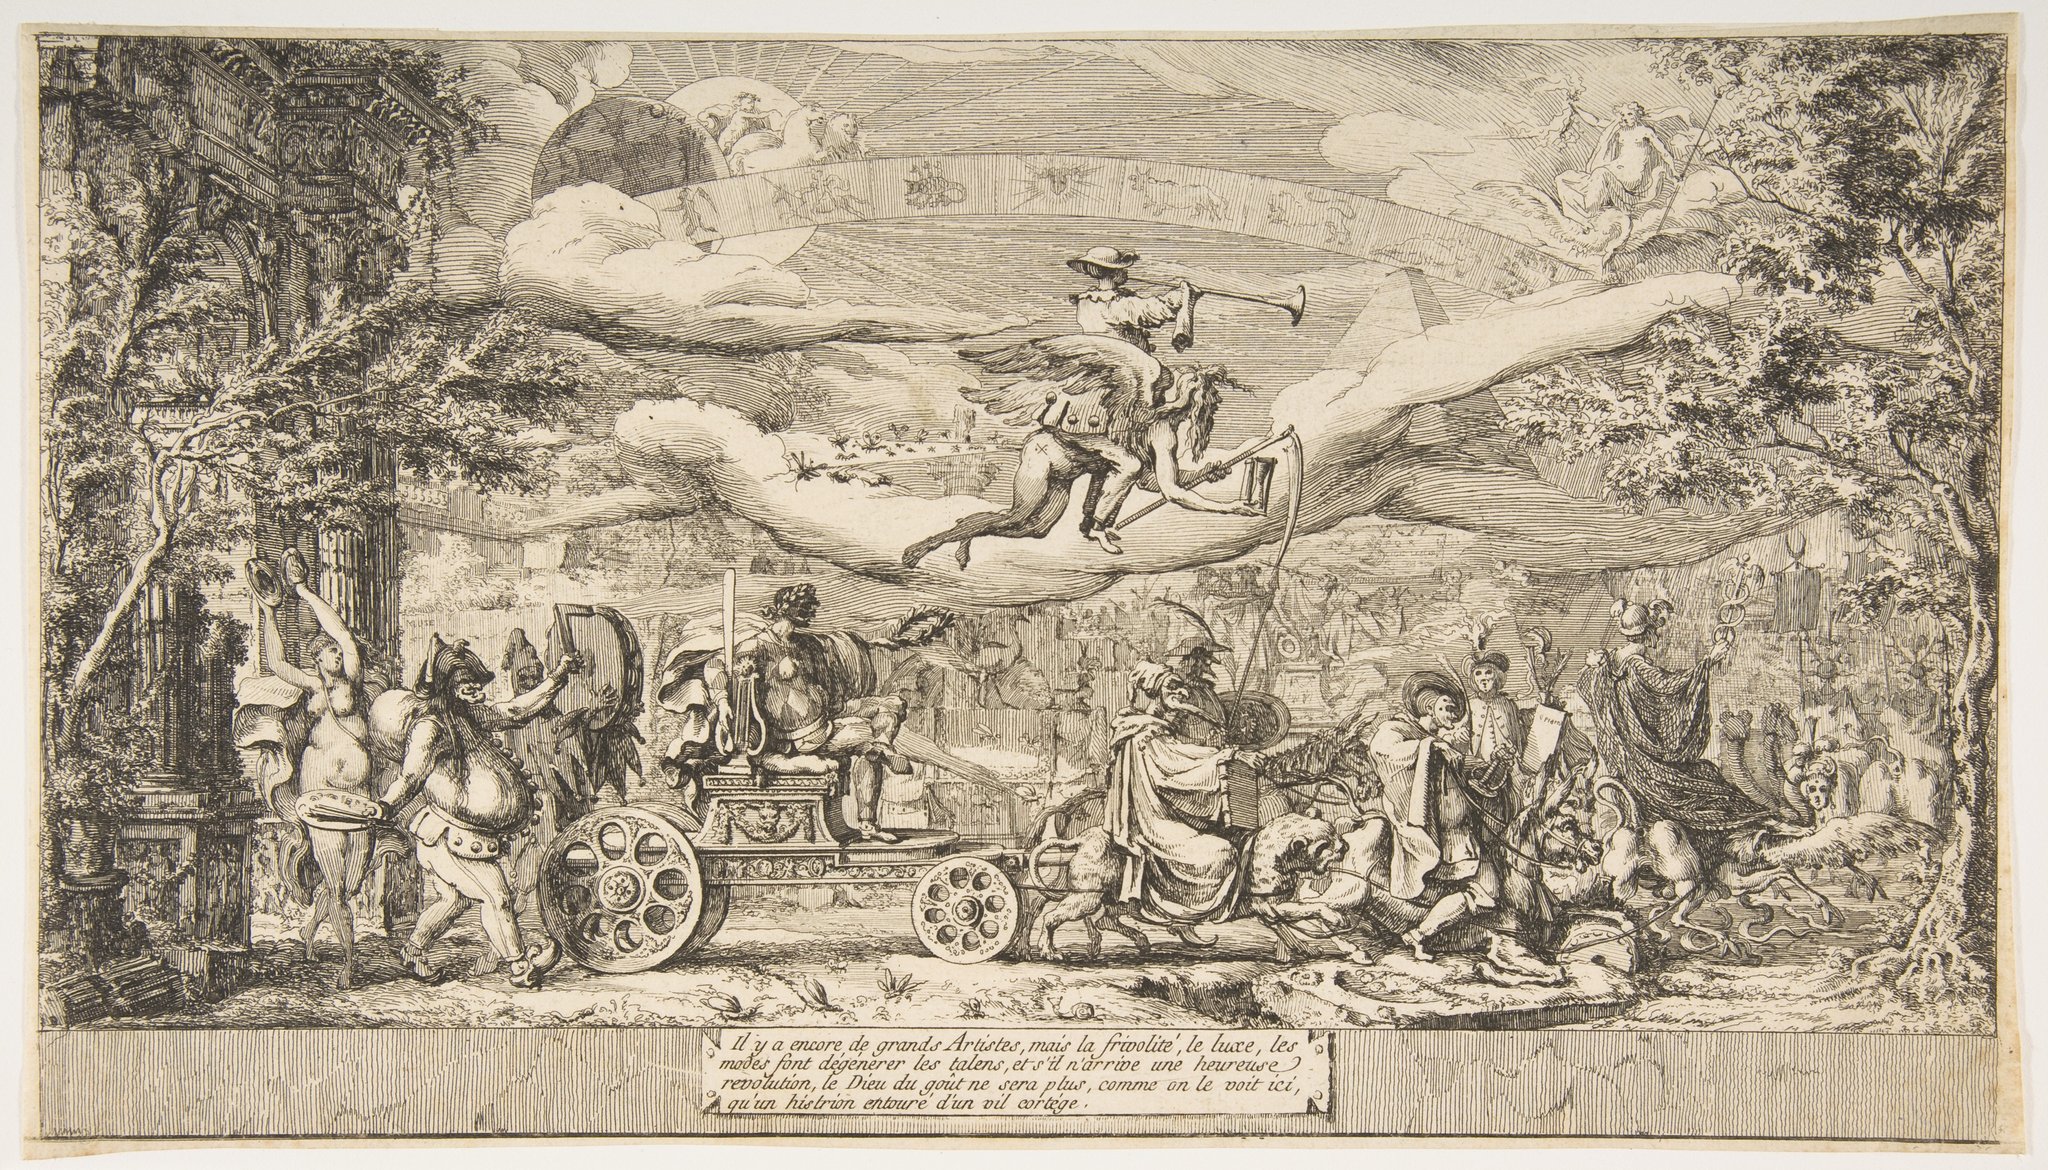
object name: print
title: The Triumph of Modern Art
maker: jean barbault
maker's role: artist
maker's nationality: french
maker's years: 1718-1762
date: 1701-1800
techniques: etching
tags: animals,men,carriages